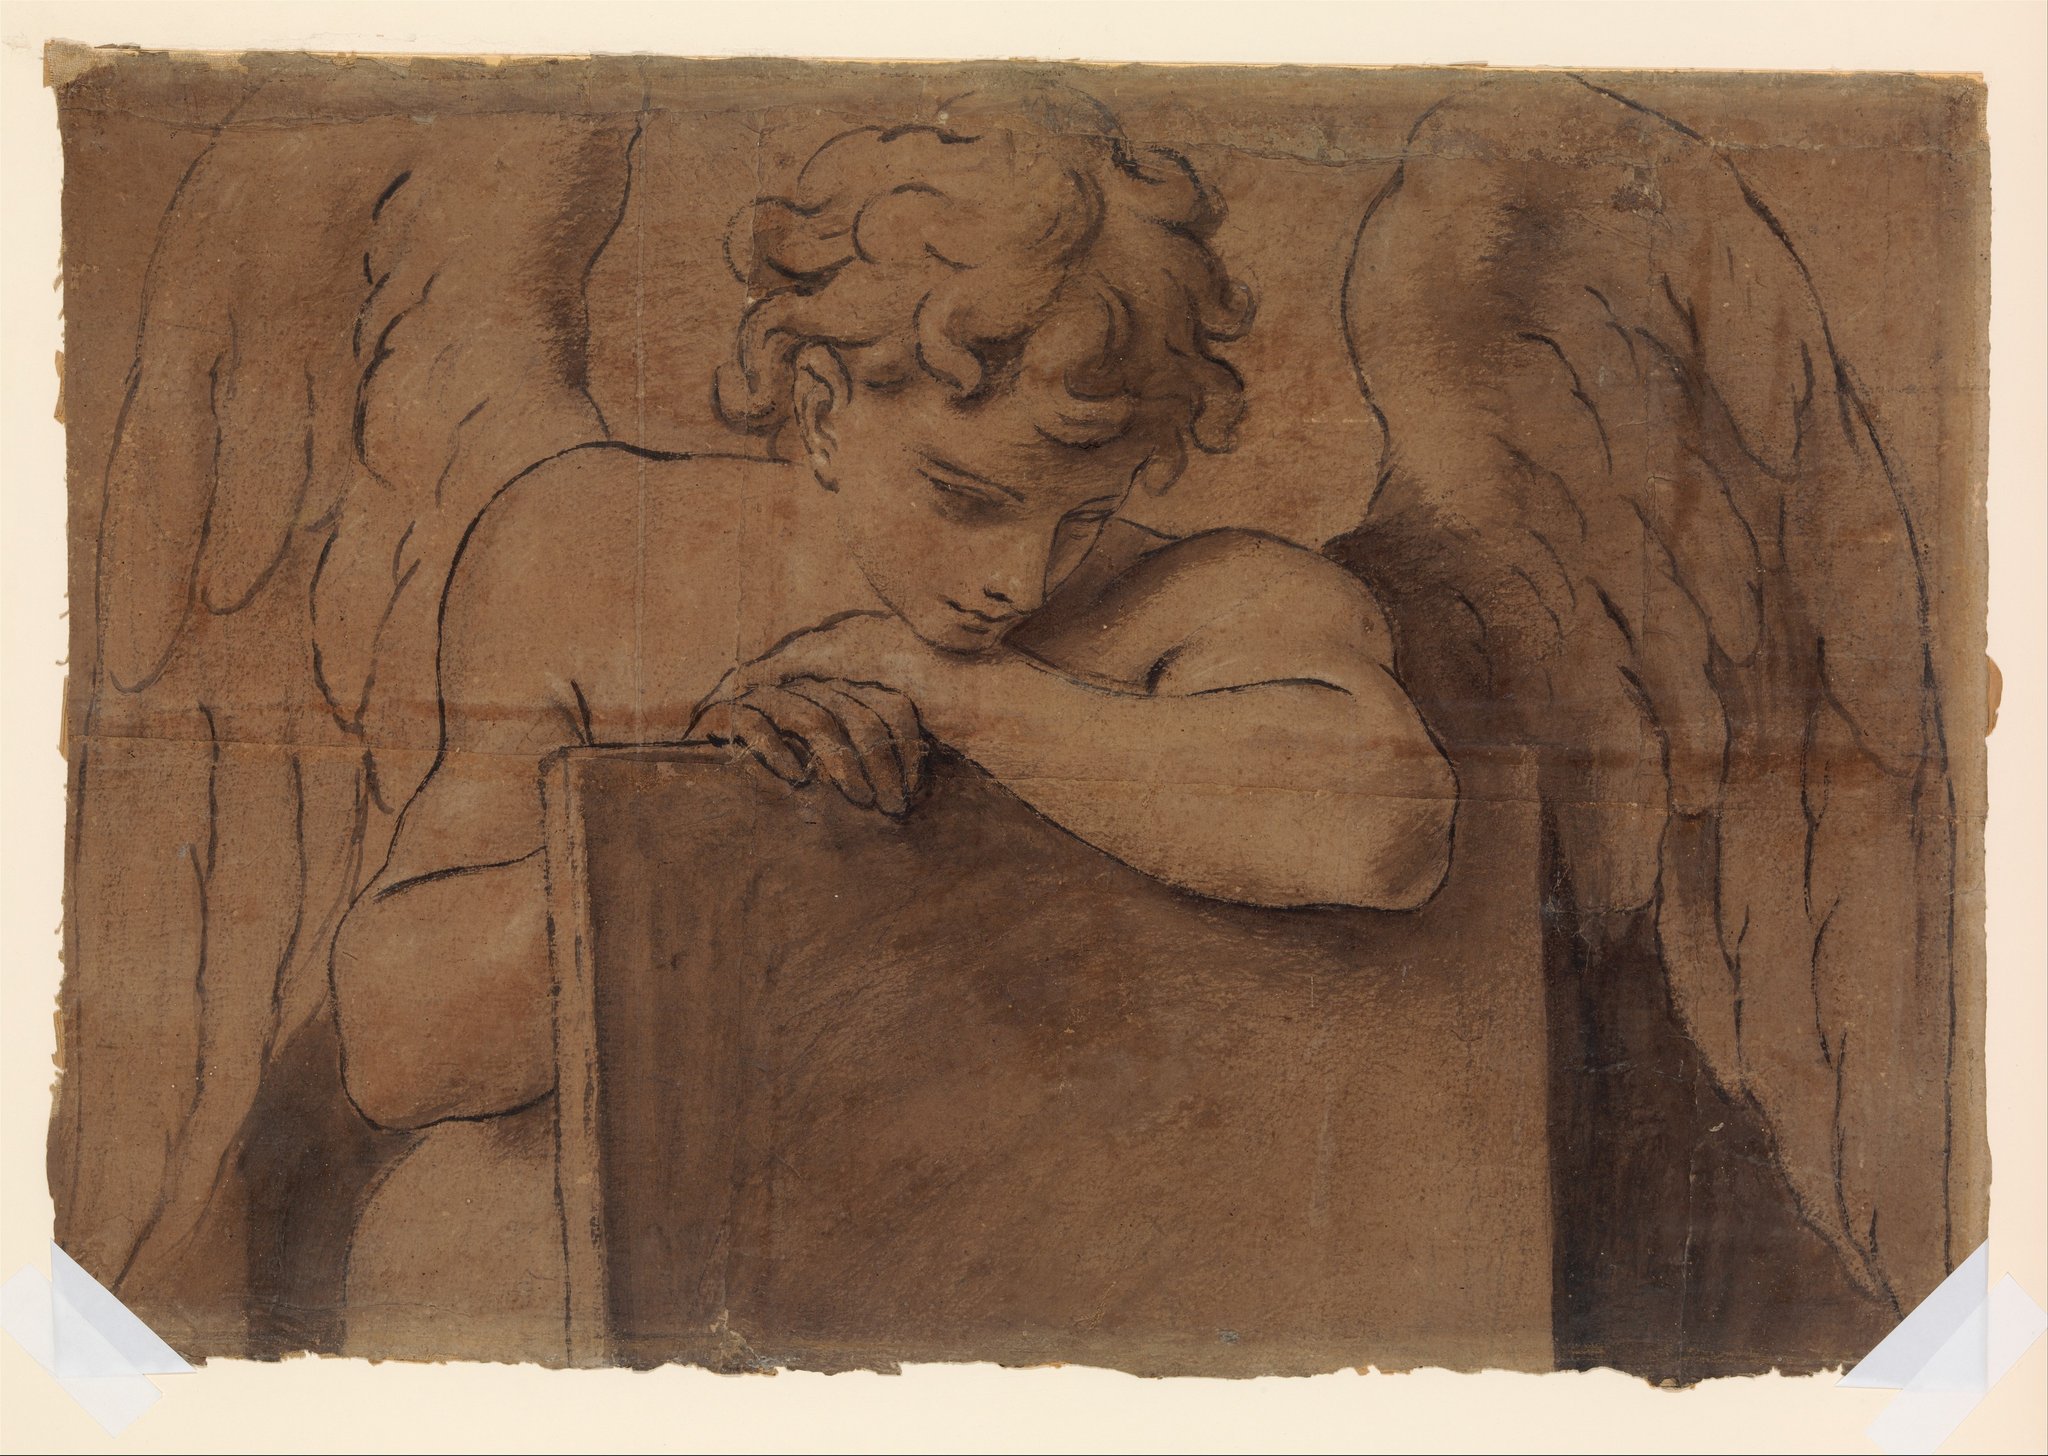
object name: drawing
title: Cartoon Fragment for Adolescent Angel Leaning on a Tablet or Closed Book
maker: marcantonio franceschini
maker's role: artist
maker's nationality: italian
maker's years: 1648-1729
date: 1690-1695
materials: canvas, charcoal, gouache, paper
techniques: brush, drawing, wash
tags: books,tablets,angels